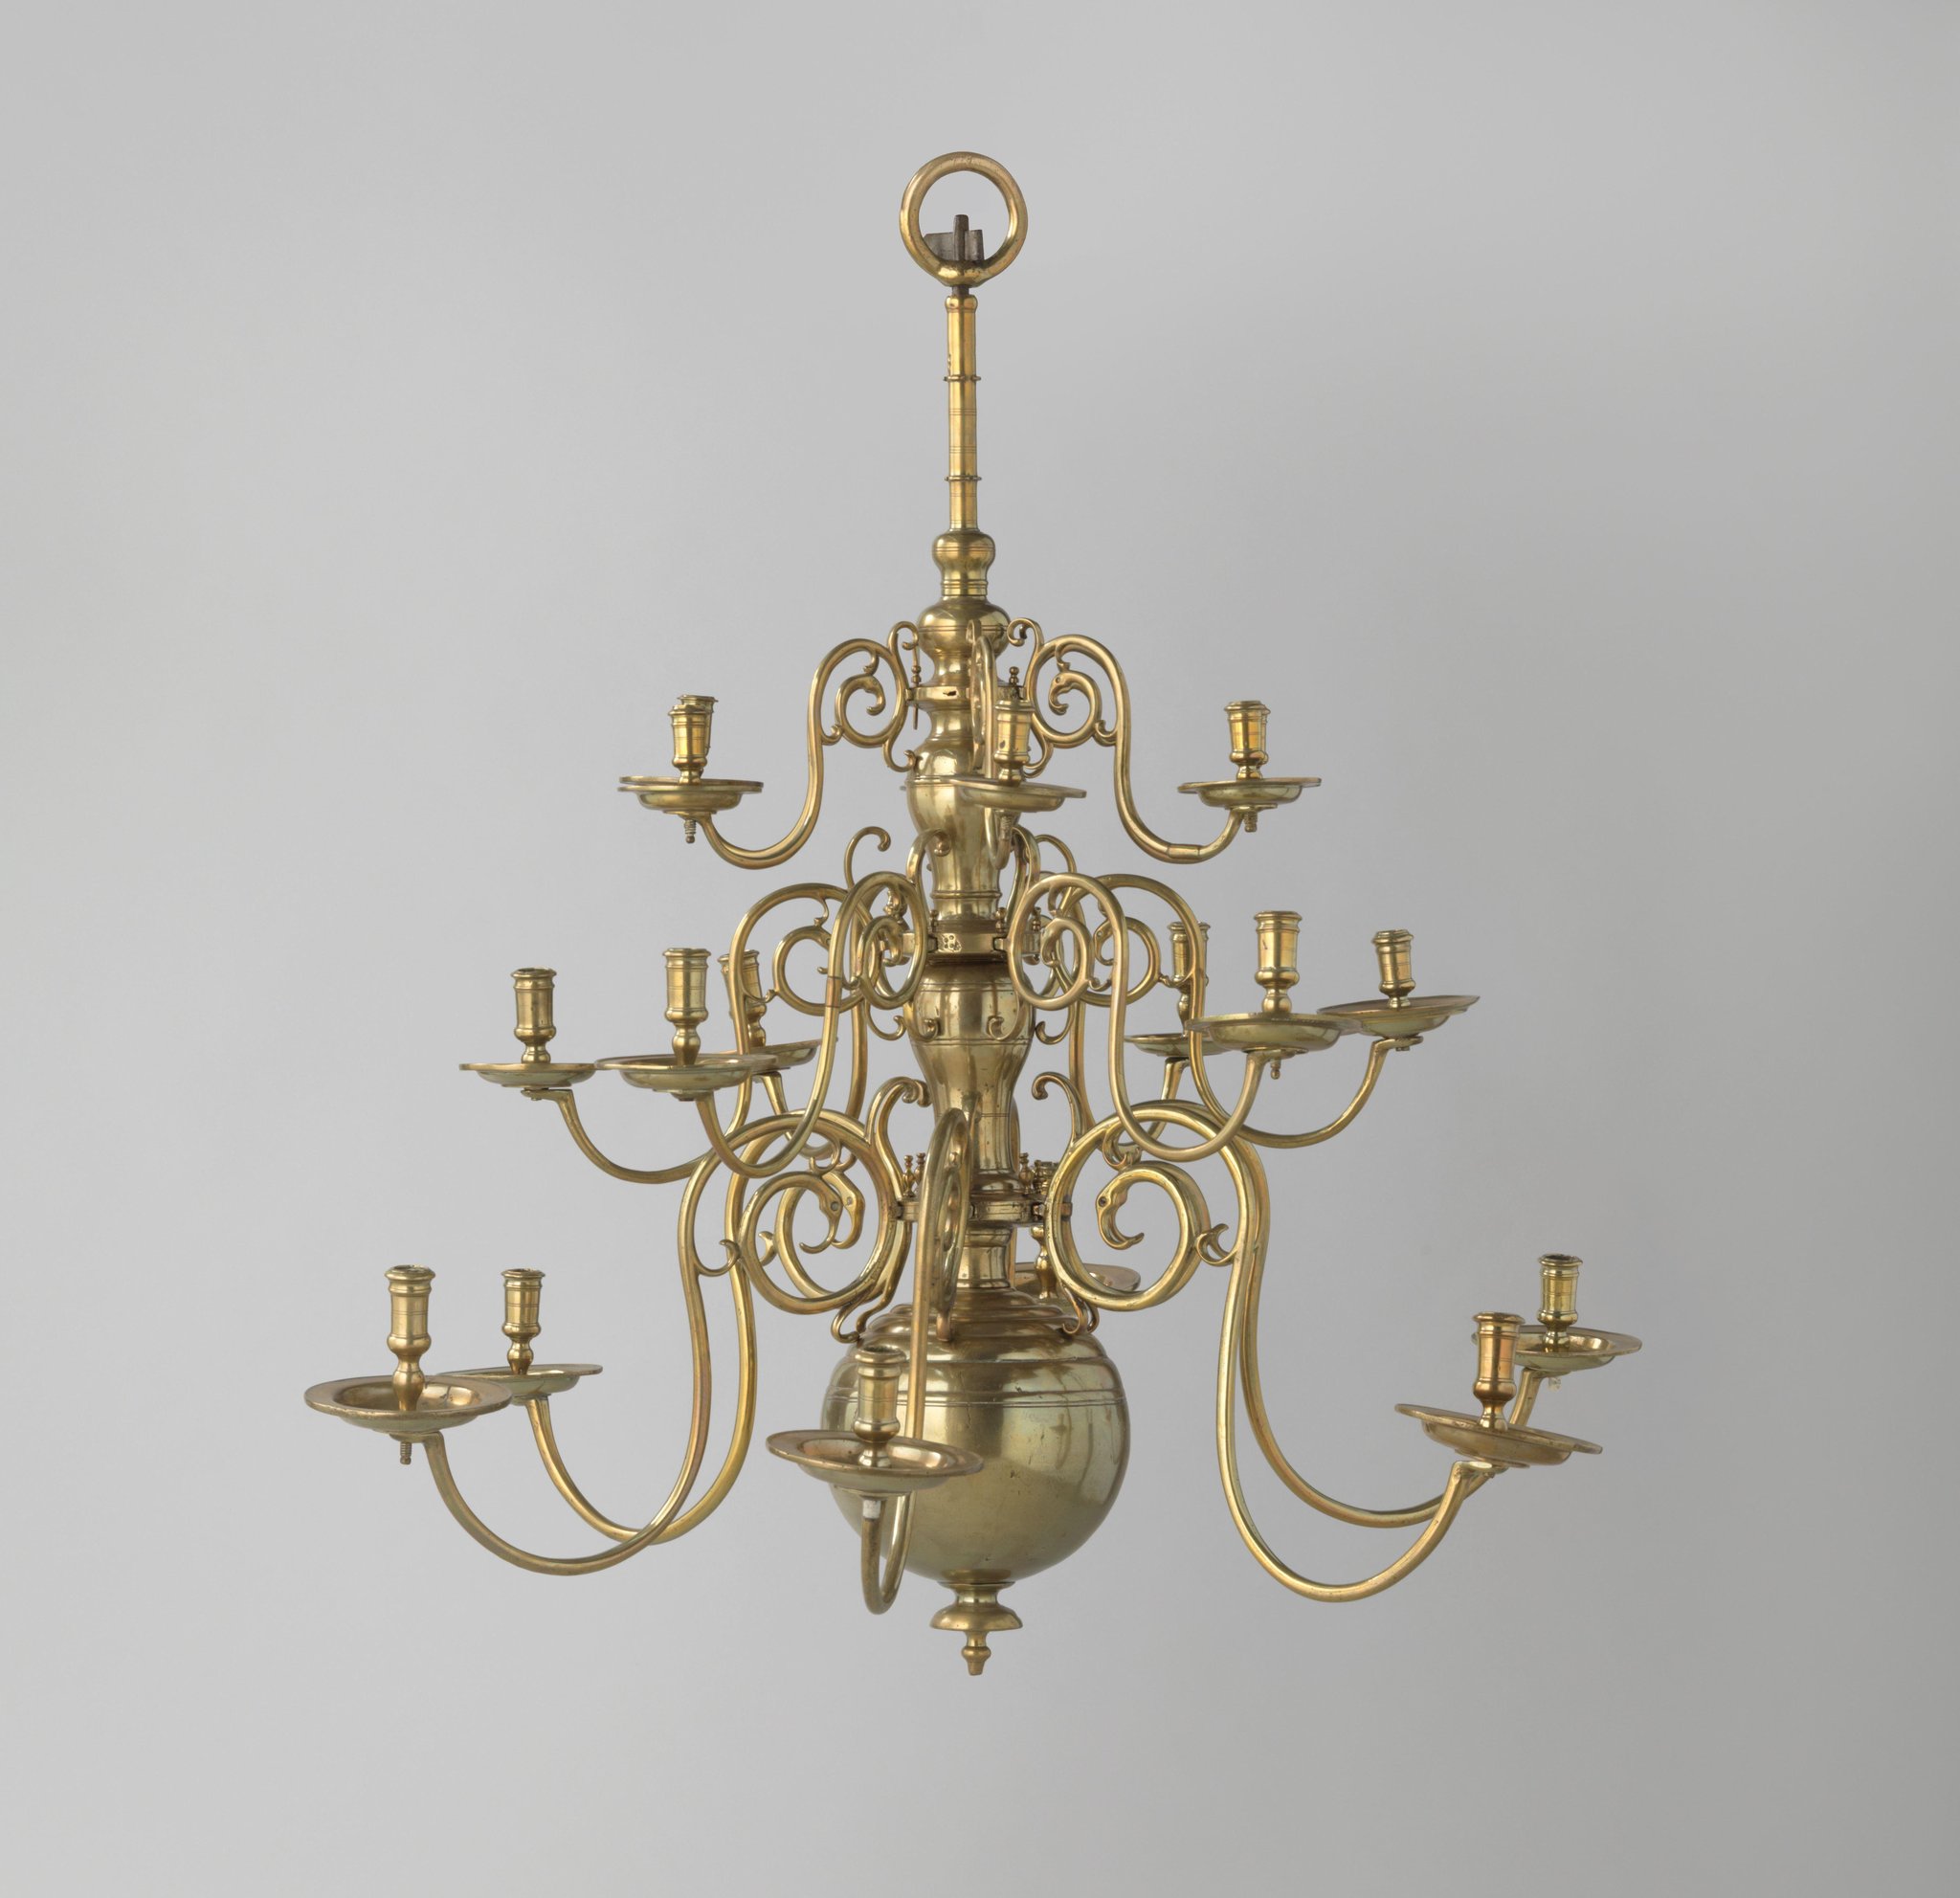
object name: chandelier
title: Arm met kaarsenhouder van kaarsenkroon van drie hoogten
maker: Anonymous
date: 1675-1725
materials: brass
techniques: casting, turning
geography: southern netherlands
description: Kaarsenarm behorende bij een messing kaarsenkroon van drie hoogten. De S-vormige arm heeft een krul en gaat naar buiten toe over in het platte verdikking met een schroefgat. Daarin is de kaarsenhouder met de vetvanger vastgezet. De vetvanger is aan de onderzijde geribd geprofileerd rond de opening en heeft verder twee maal twee gegroefde ringen. De cylindrische kaarsenhouder, die een geprofileerde uitstekende rand, twee gegroefde ringen en een verdikking onderaan heeft, gaat over in een baluster met onderaan het eind met schroefdraad en een knopje, waarin het centergat te zien is. Dit is de eerste arm van de bovenste standring, genummerd met 1 ronde punt. De pin, om de arm aan de standring te bevestigen, heeft bovenop een ronde knop.